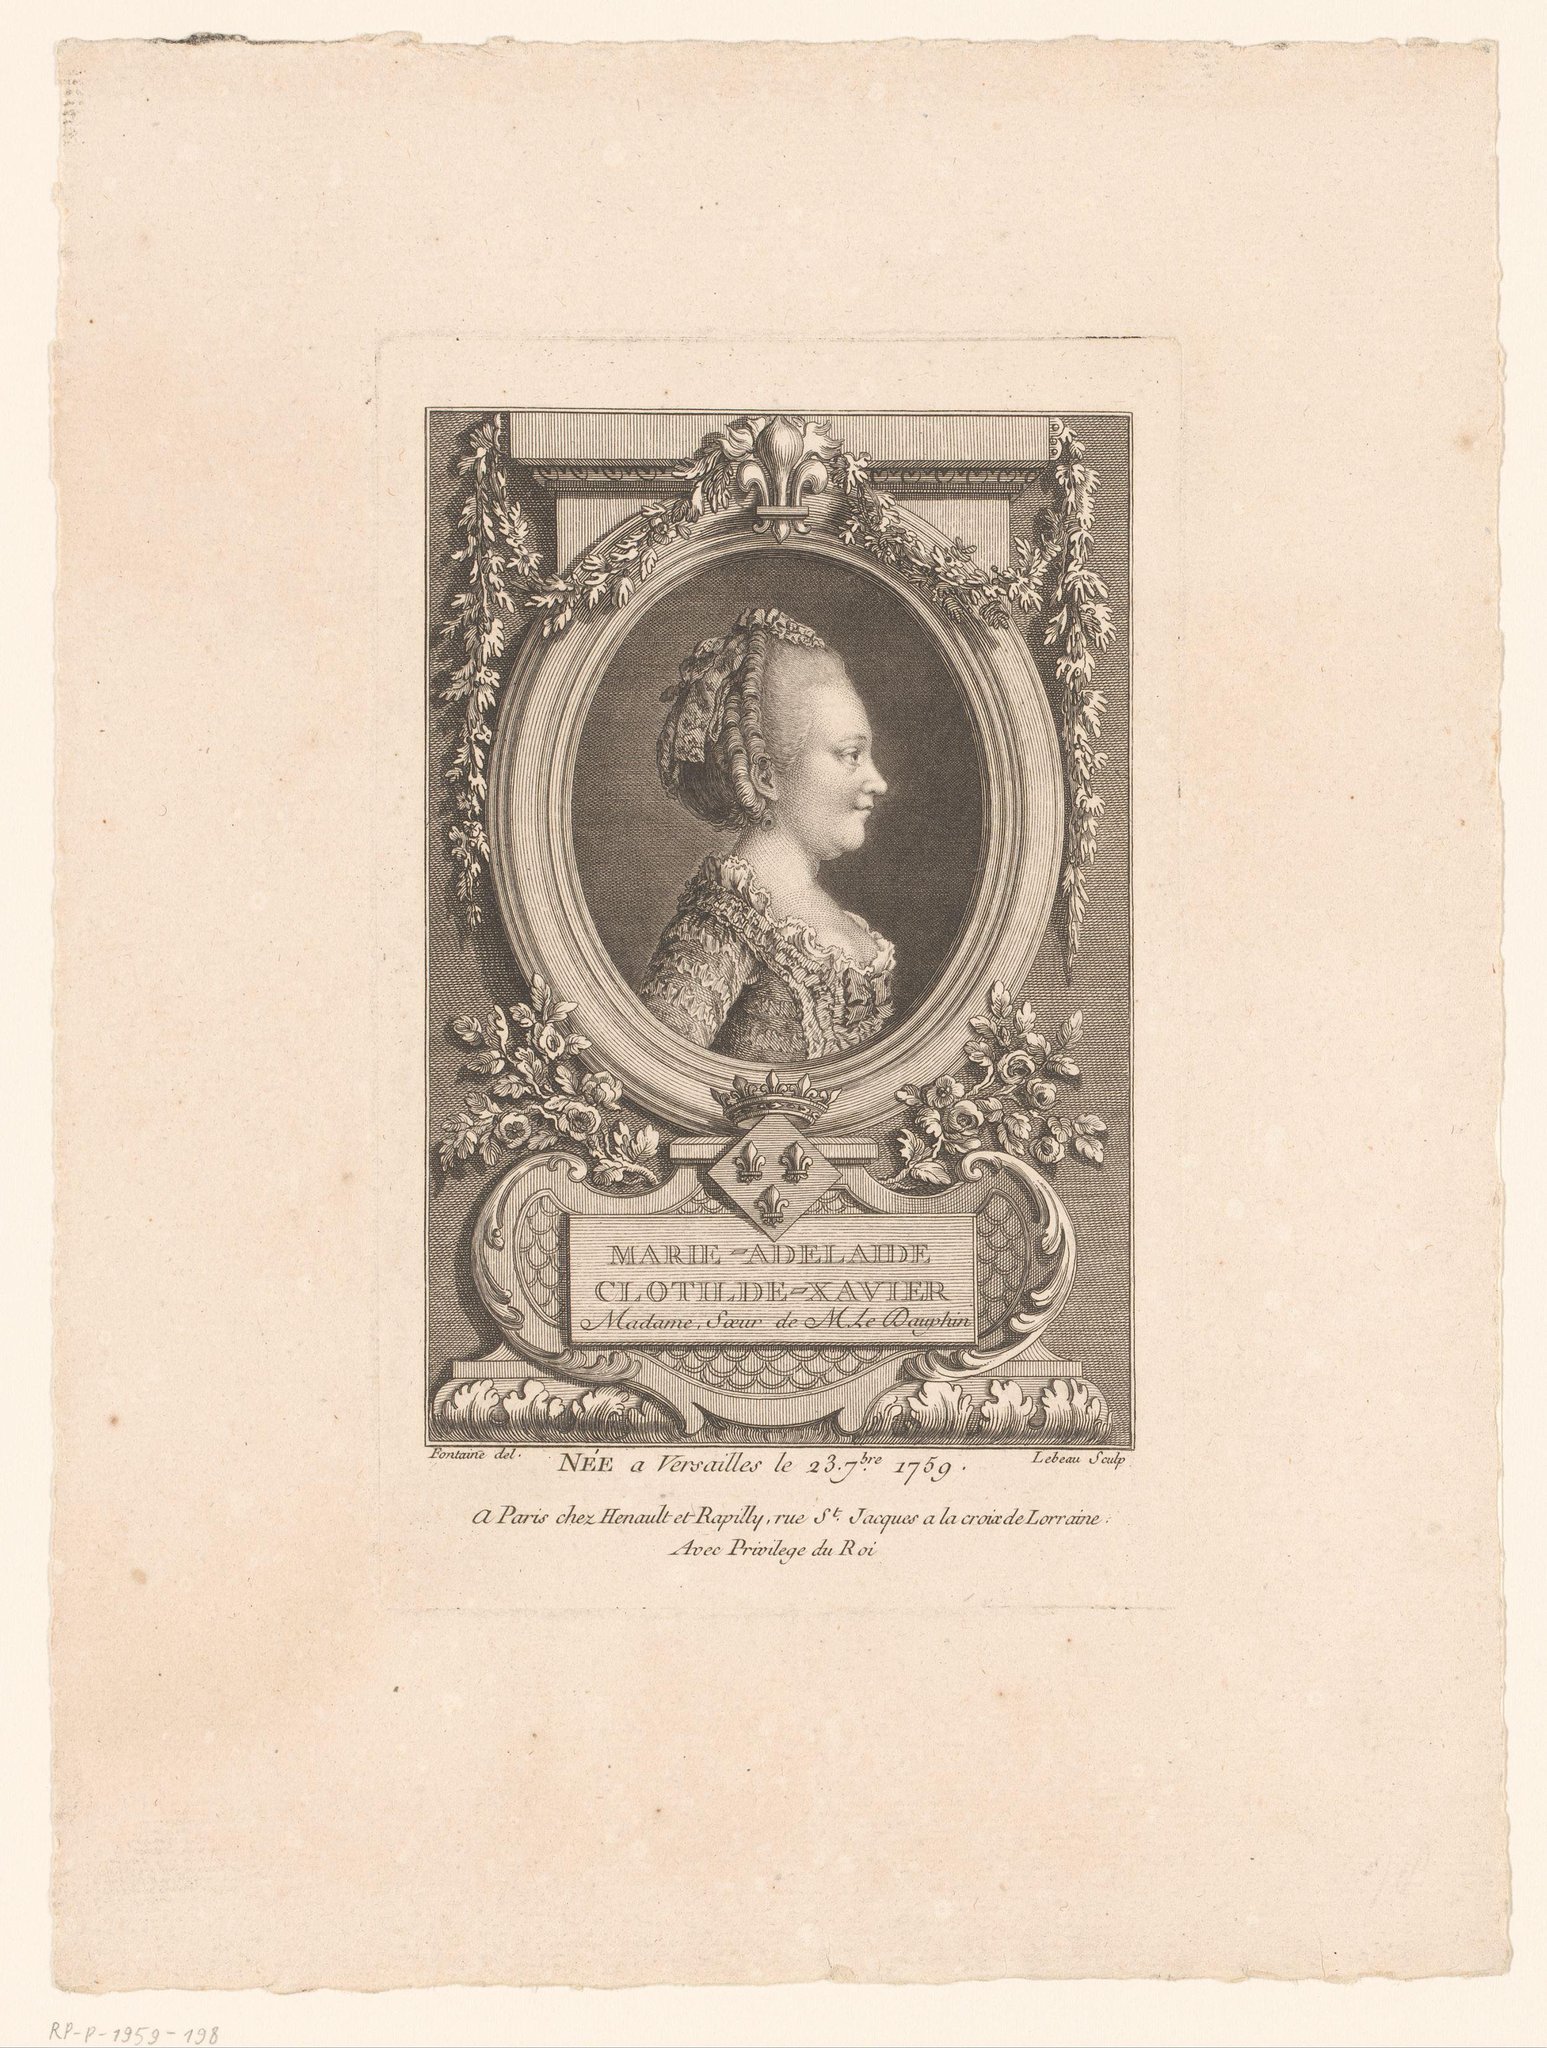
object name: print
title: Portret van Clothilde van Frankrijk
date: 1789-1806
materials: paper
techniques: engraving, etching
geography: france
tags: naples, clothilde van frankrijk, historical persons - bb - woman, ornament ~ medallion, ruler, sovereign - bb - female ruler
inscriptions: collector's mark: Lugt 2760, collector's mark: Lugt 2228